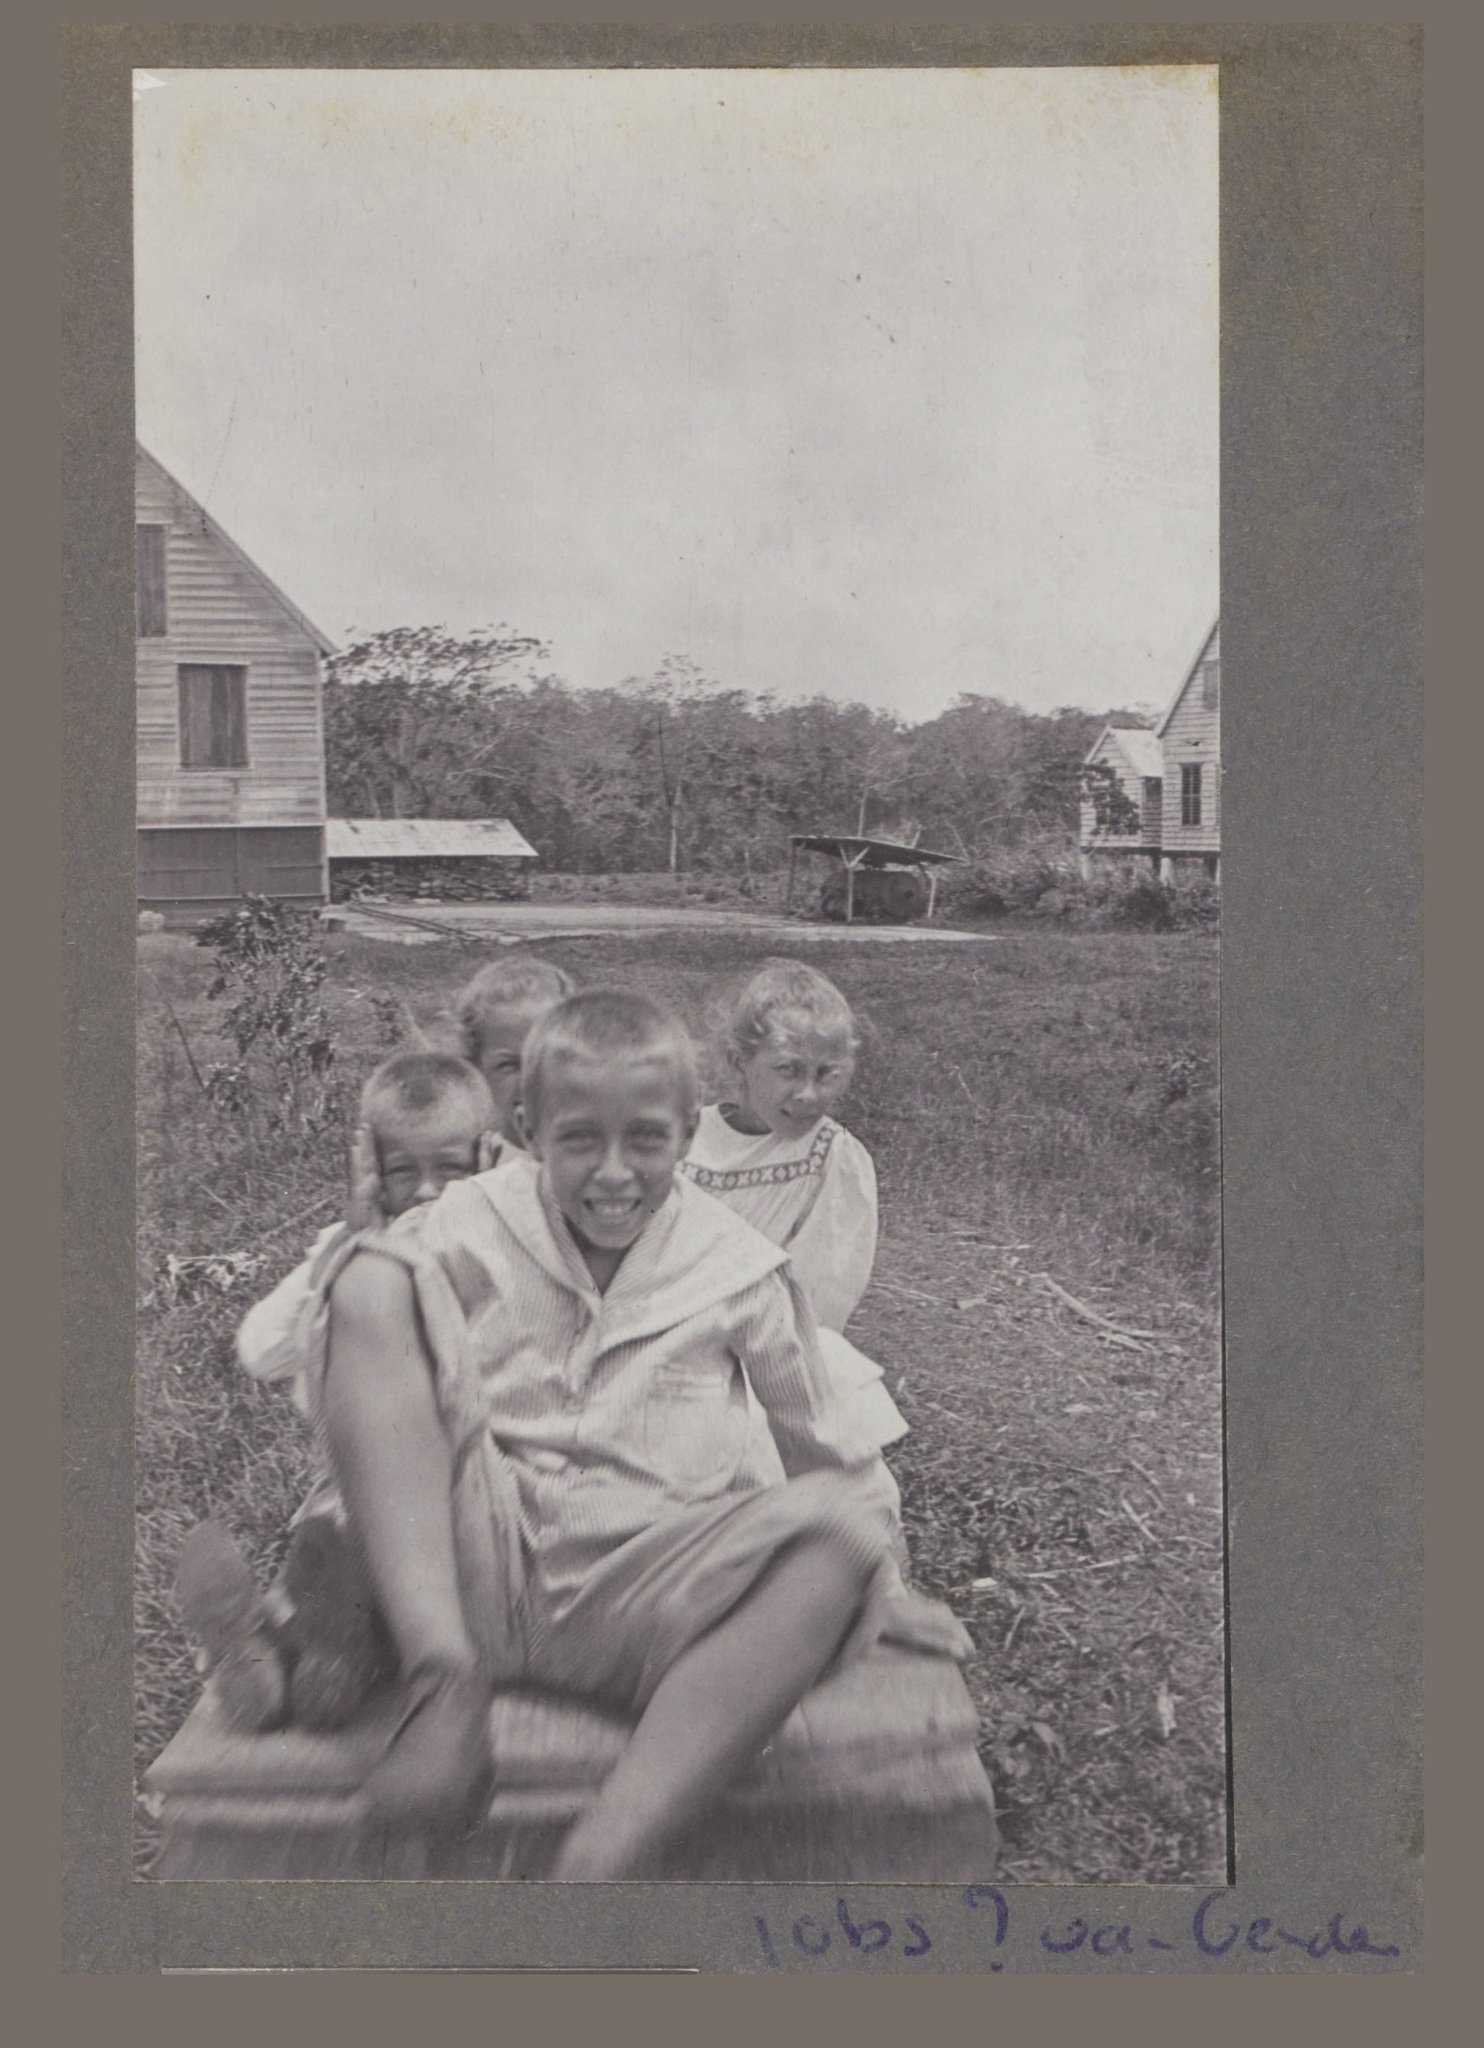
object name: photograph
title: Vier kinderen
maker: Anonymous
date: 1912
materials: photographic support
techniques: photography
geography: suriname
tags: suriname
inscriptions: inscription: ‘jobs? va - Gerde’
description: Groepsfoto van vier kinderen zittend op een steen. Onderdeel van het fotoalbum over het leven van de familie Gonggrijp in Suriname rond 1912.